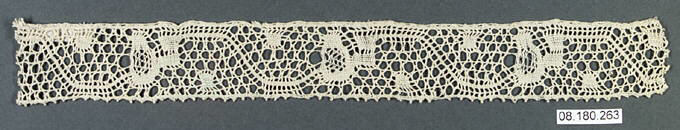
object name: fragment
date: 1801-1900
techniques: lace